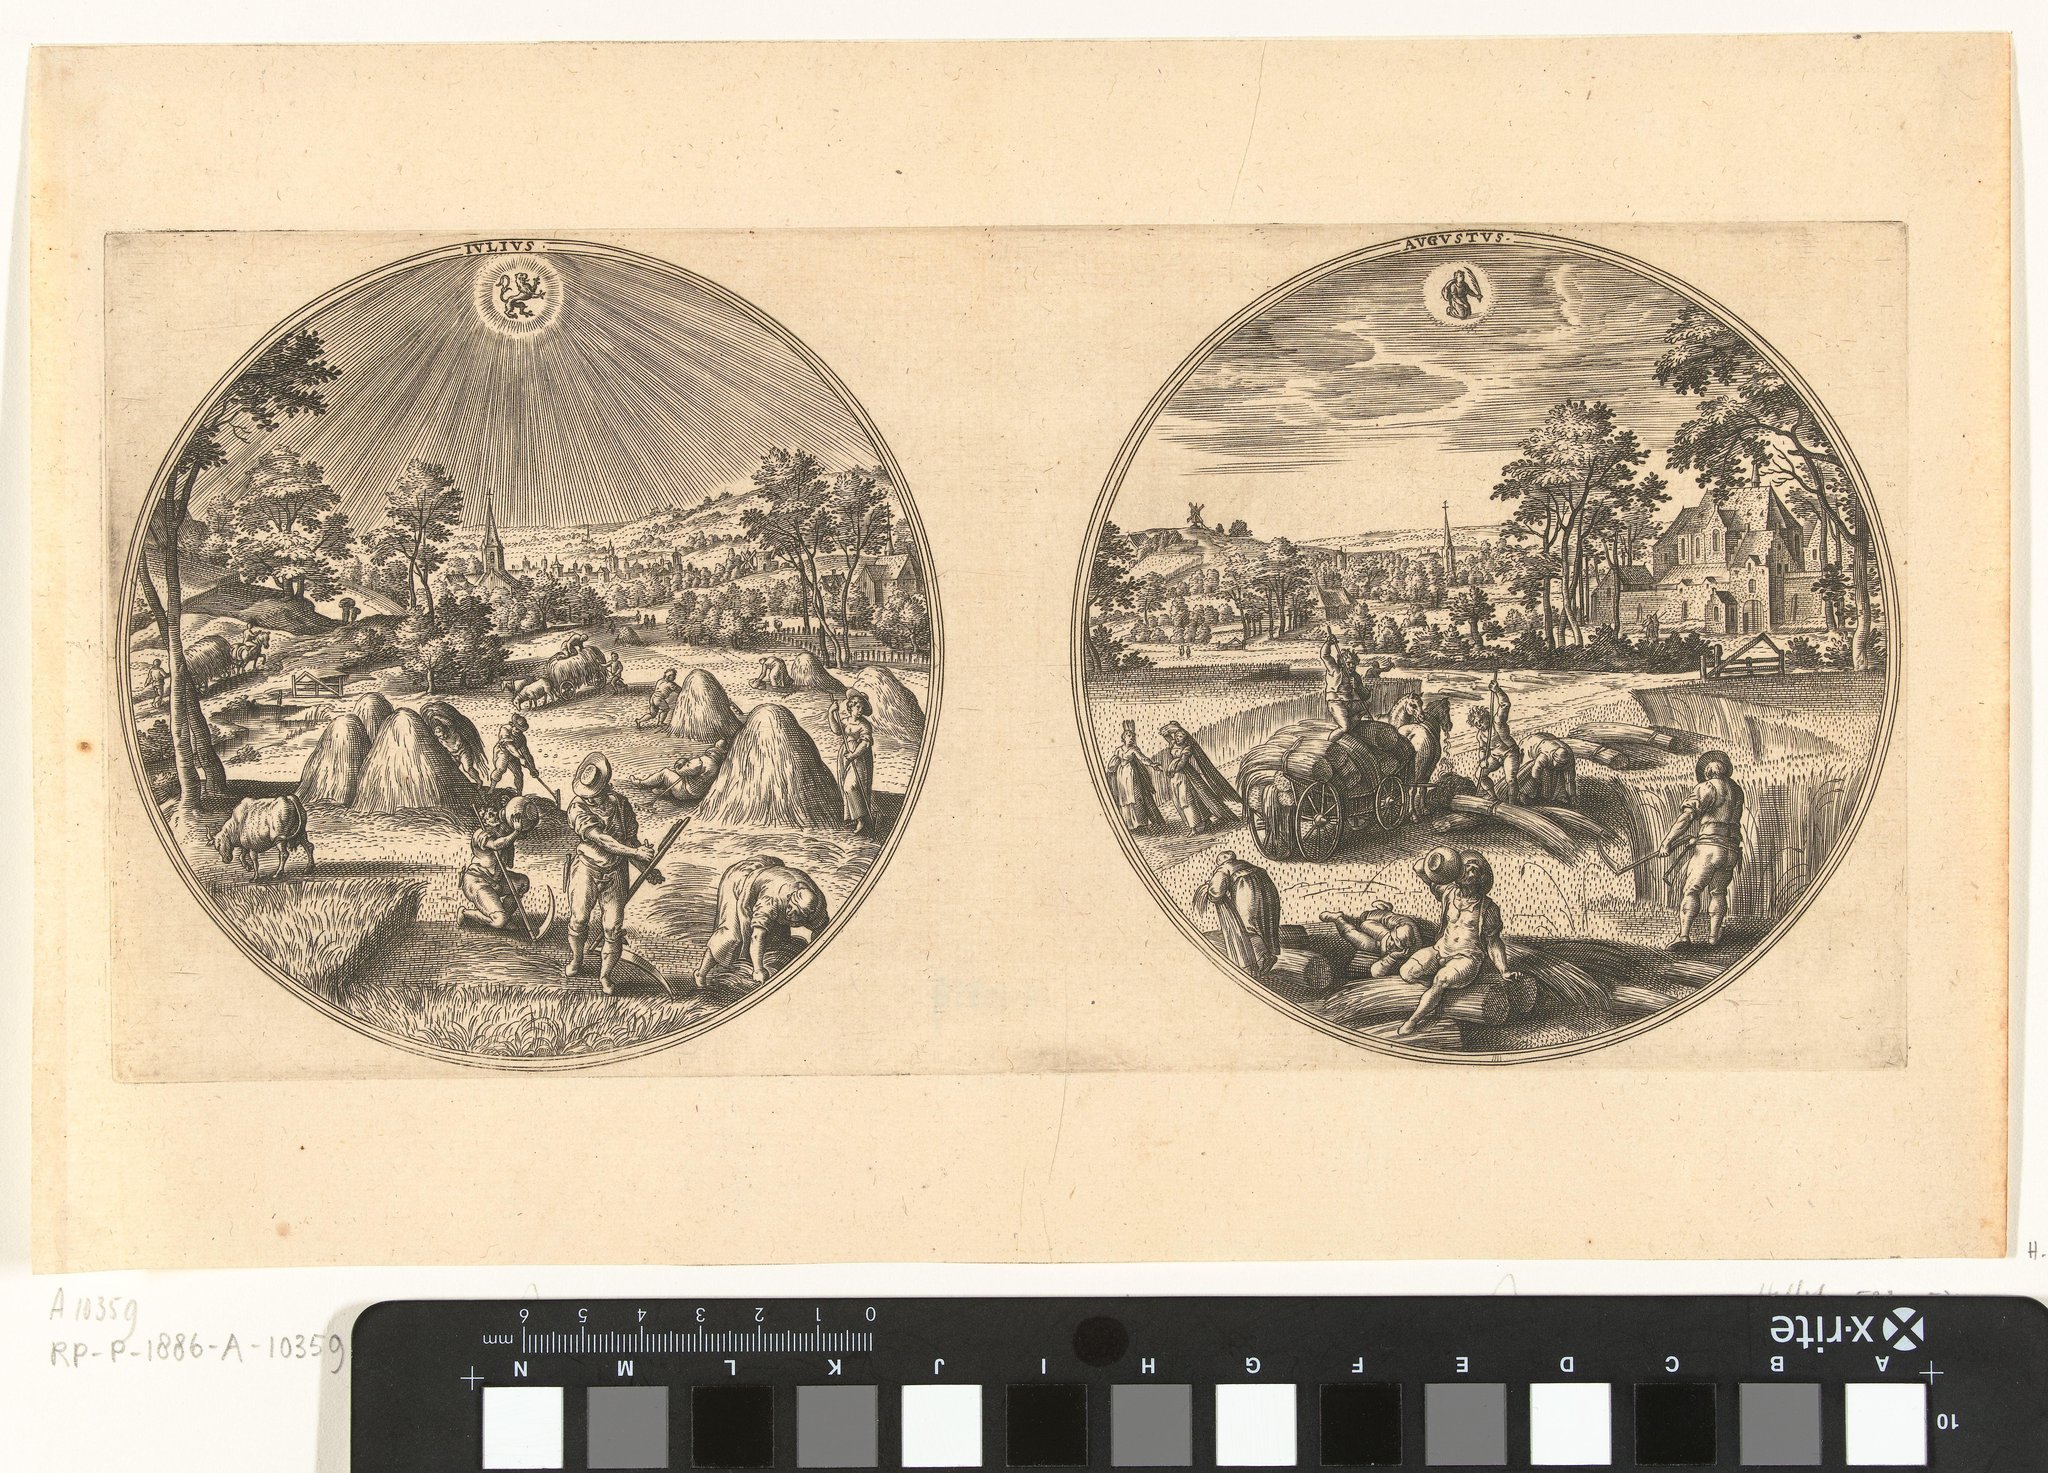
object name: print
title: De twaalf maanden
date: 1578-1582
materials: paper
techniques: engraving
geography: antwerp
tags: hay-stack, hay-wagon, rest during harvest (eating, dancing, making love, etc.), july and its 'labours' (+ with zodiacal signs), reaping, picking, mowing ~ harvest, august and its 'labours' (+ with zodiacal signs)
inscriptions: collector's mark: Lugt 2228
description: Twee ronde lijsten met zomerlandschappen en zomertaferelen. Links juli, de maai- of hooimaand. Centraal staat het hooien en het maaien van het gras. Hooiwagens brengen het gemaaide gras naar de schuur. Middenboven het sterrenbeeld Leeuw. Rechts augustus, de oogstmaand. Centraal staat het oogsten van graan. Oogstwagens brengen het graan naar de schuur. Enkele landbouwers zijn juist toe aan hun rustpauze. Middenboven het sterrenbeeld Maagd., De prent is deel van een serie over de twaalf maanden.